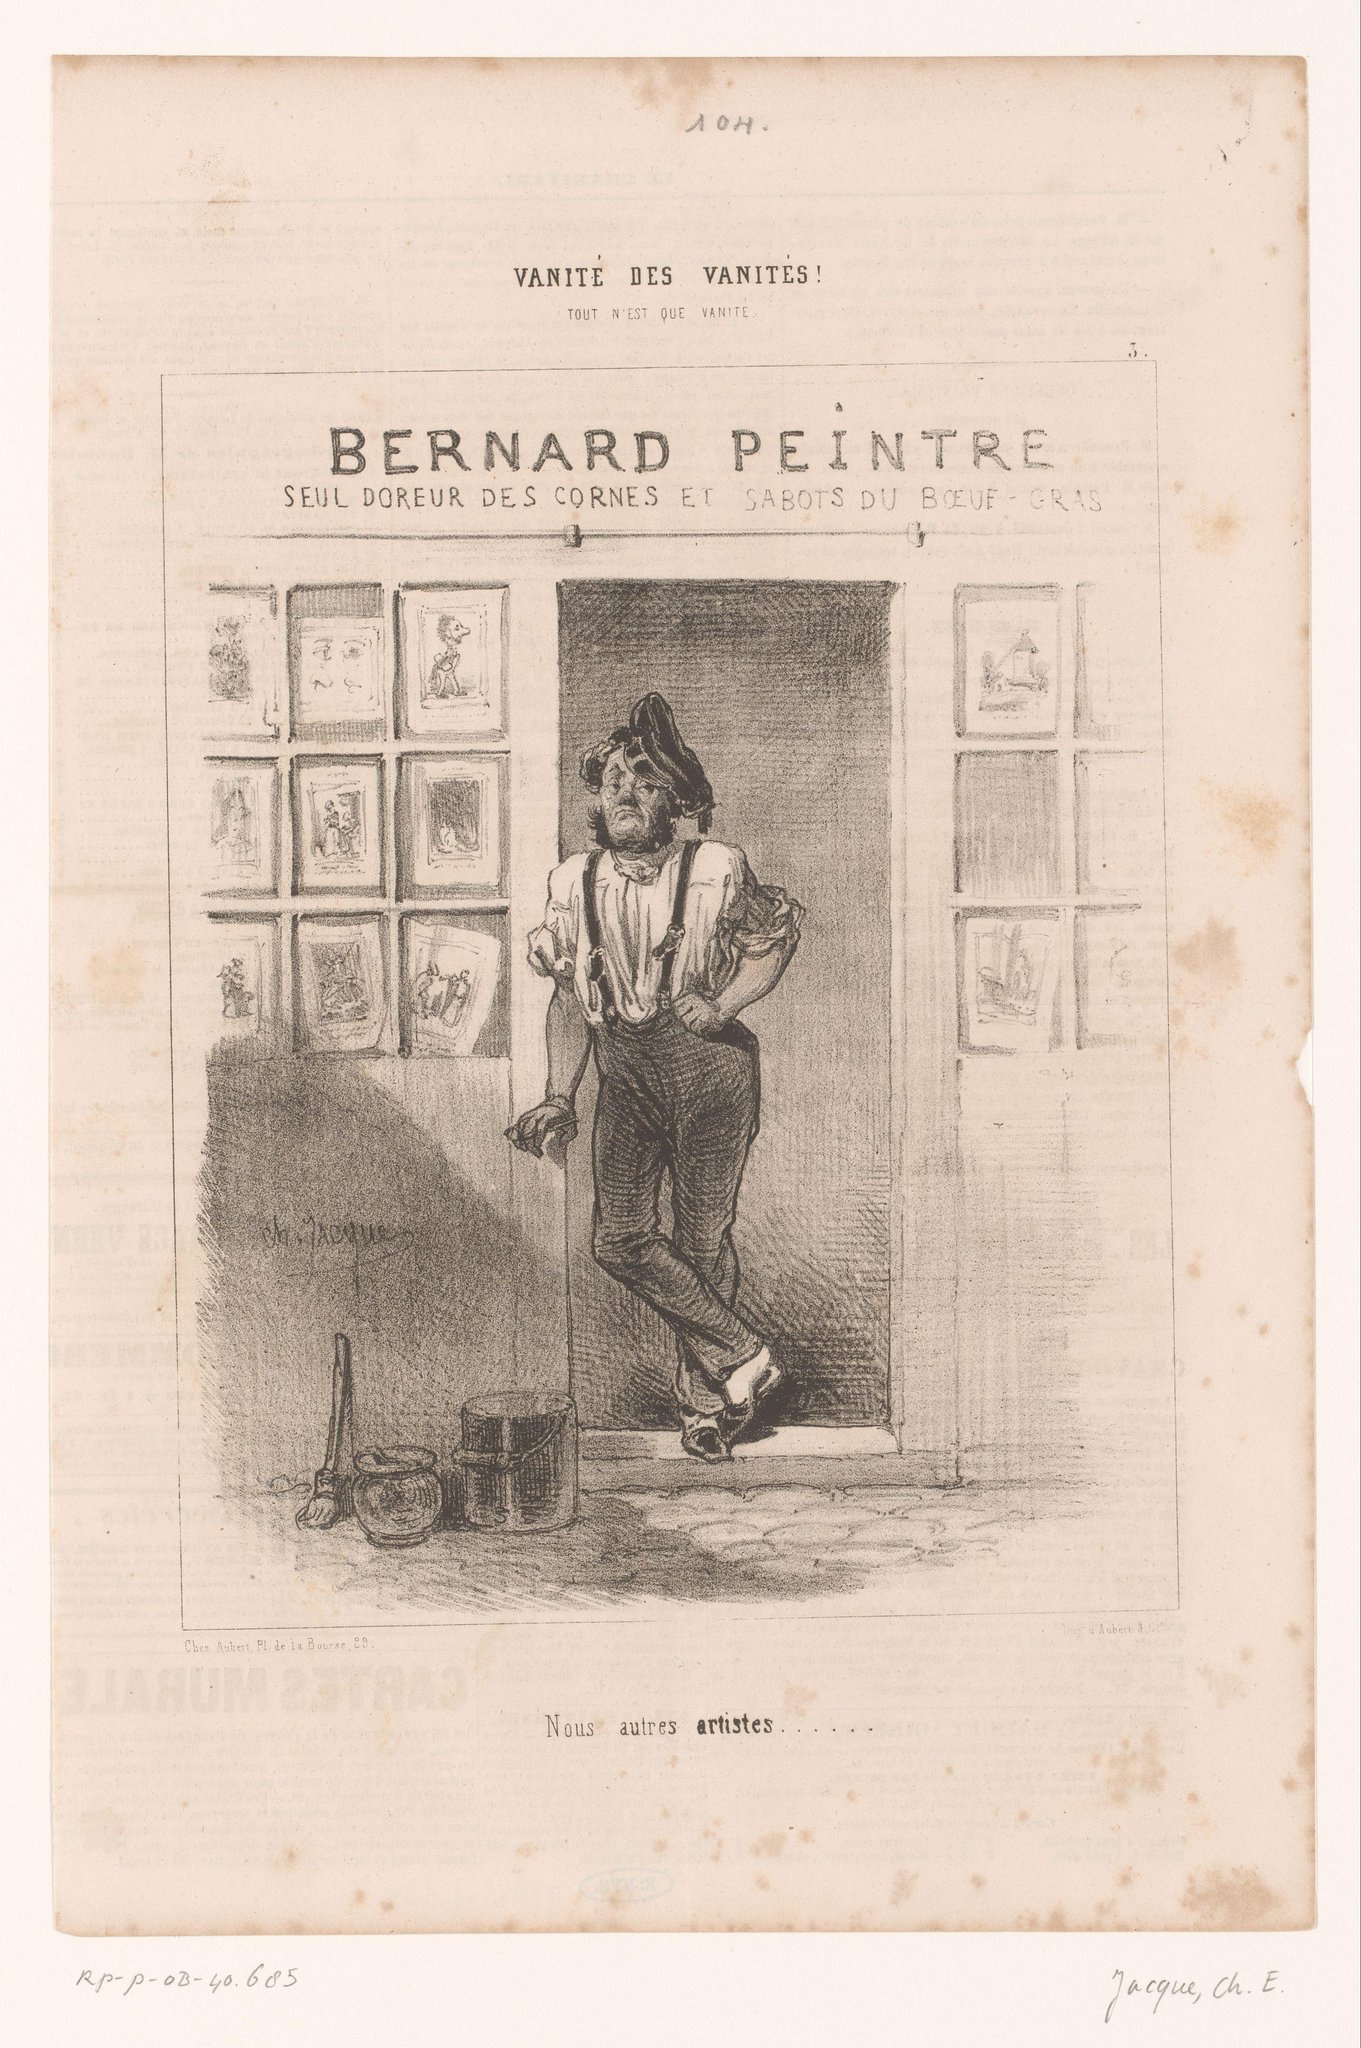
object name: cartoon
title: Vanité des Vanités! Tout n'est que vanité!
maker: charles emile jacque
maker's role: draughtsman, painter, print maker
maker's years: 1813-1894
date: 1843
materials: paper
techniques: lithograph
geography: paris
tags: stile, post, doorjamb, workshop, studio ~ painter - cc - out of doors, painter in non-work situation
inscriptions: collector's mark: Lugt 2228a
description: Prent gebruikt voor: Le Charivari, 1843.